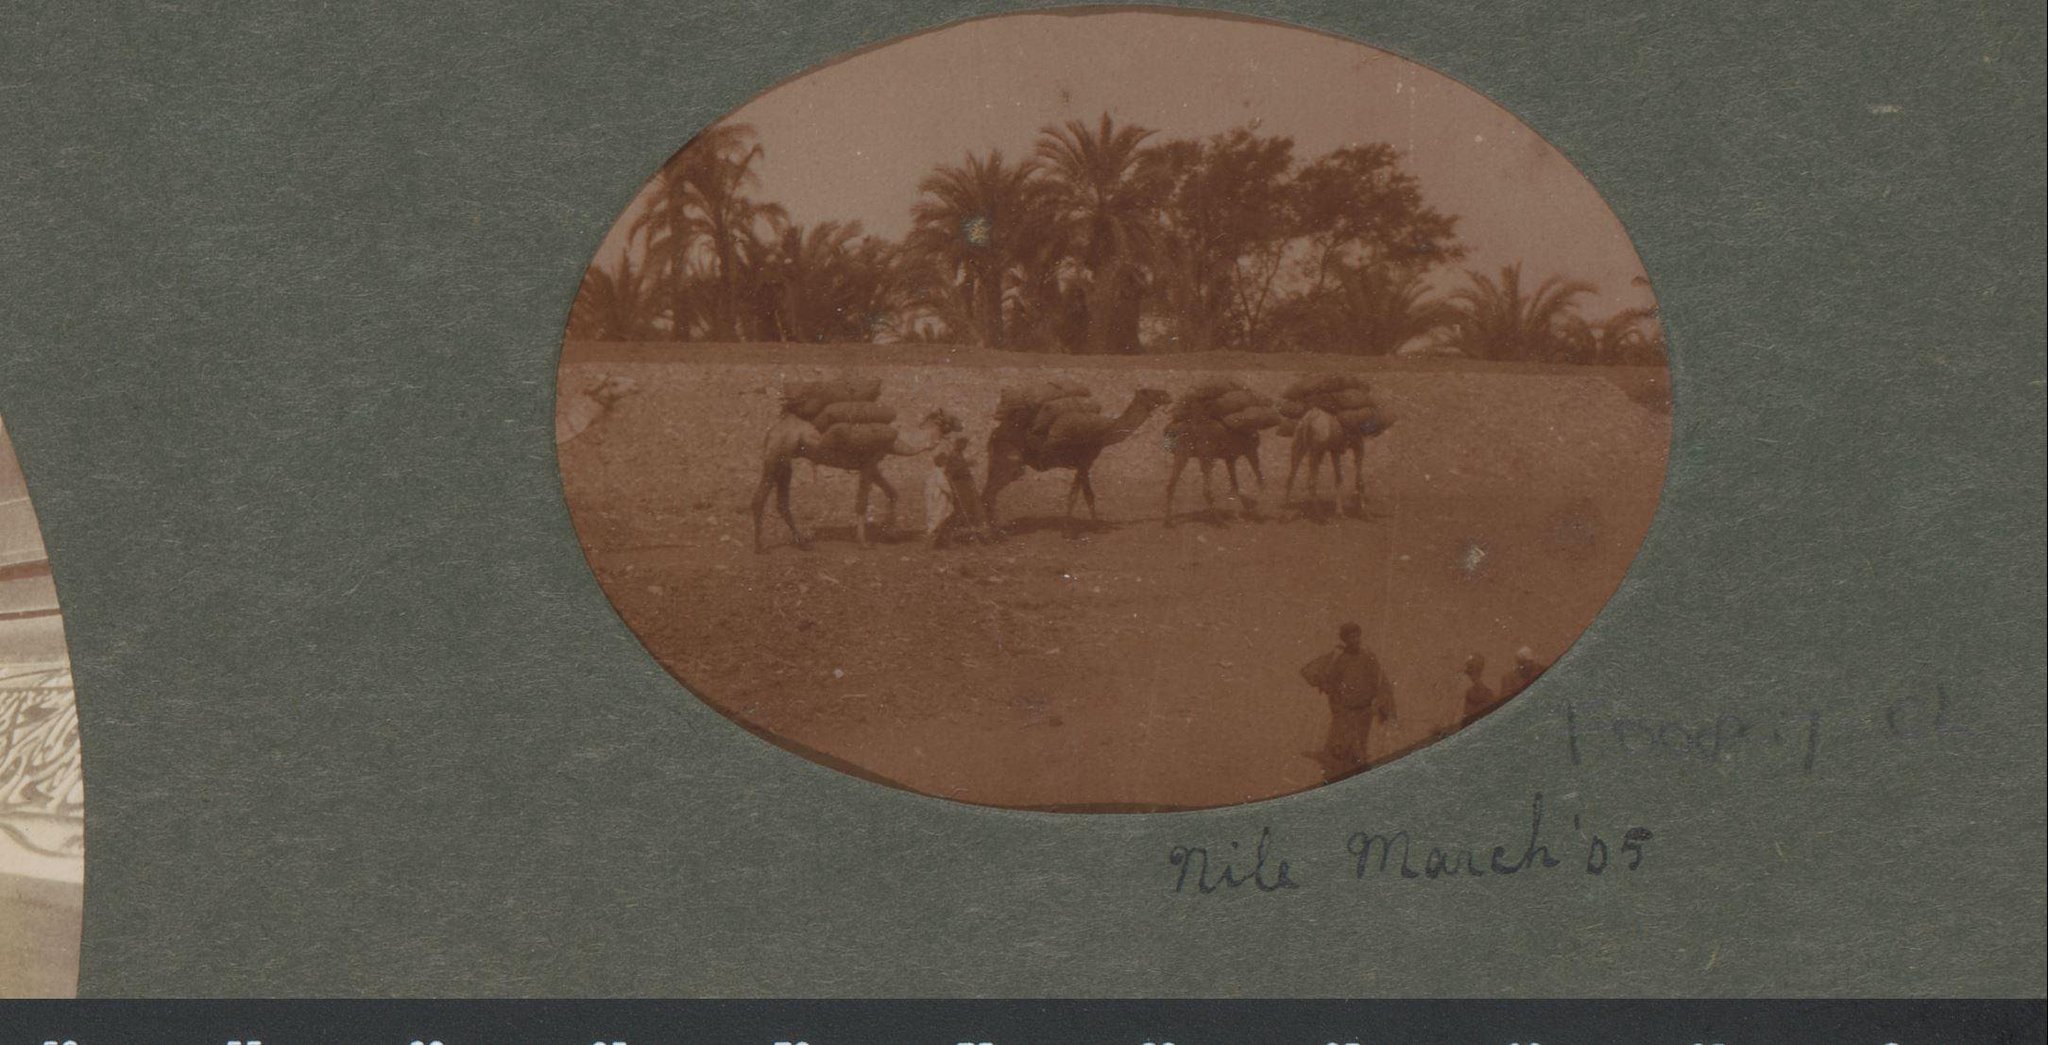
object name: album leaf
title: Bepakte kamelen langs de Nijl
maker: Anonymous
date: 1903-1905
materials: cardboard, paper, photographic support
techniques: collodion silver print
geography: nile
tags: hoofed animals, animal mounts; pack-animals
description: Onderdeel van Reisalbum van een Nederlandse familie met bezienswaardigheden in Europa, Egypte en New York.